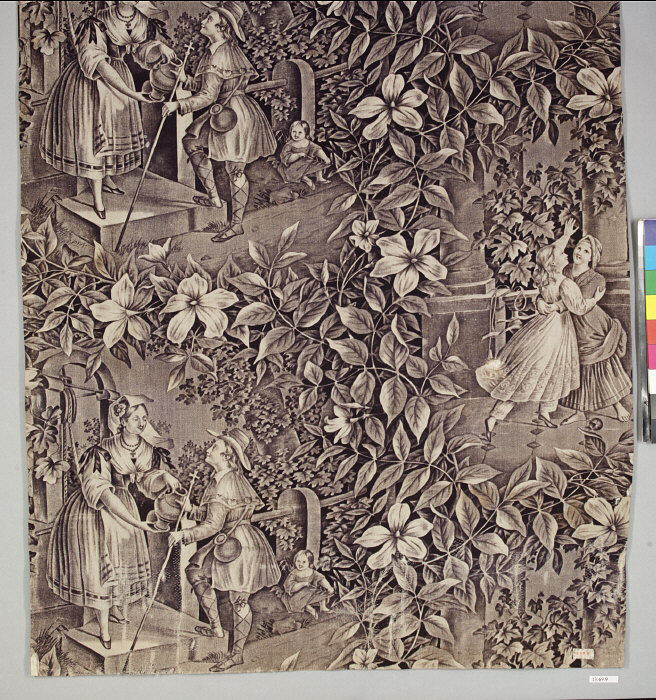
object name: furnishing textile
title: Pictorial print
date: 1801-1833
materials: cotton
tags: girls,men,women,flowers,leaves